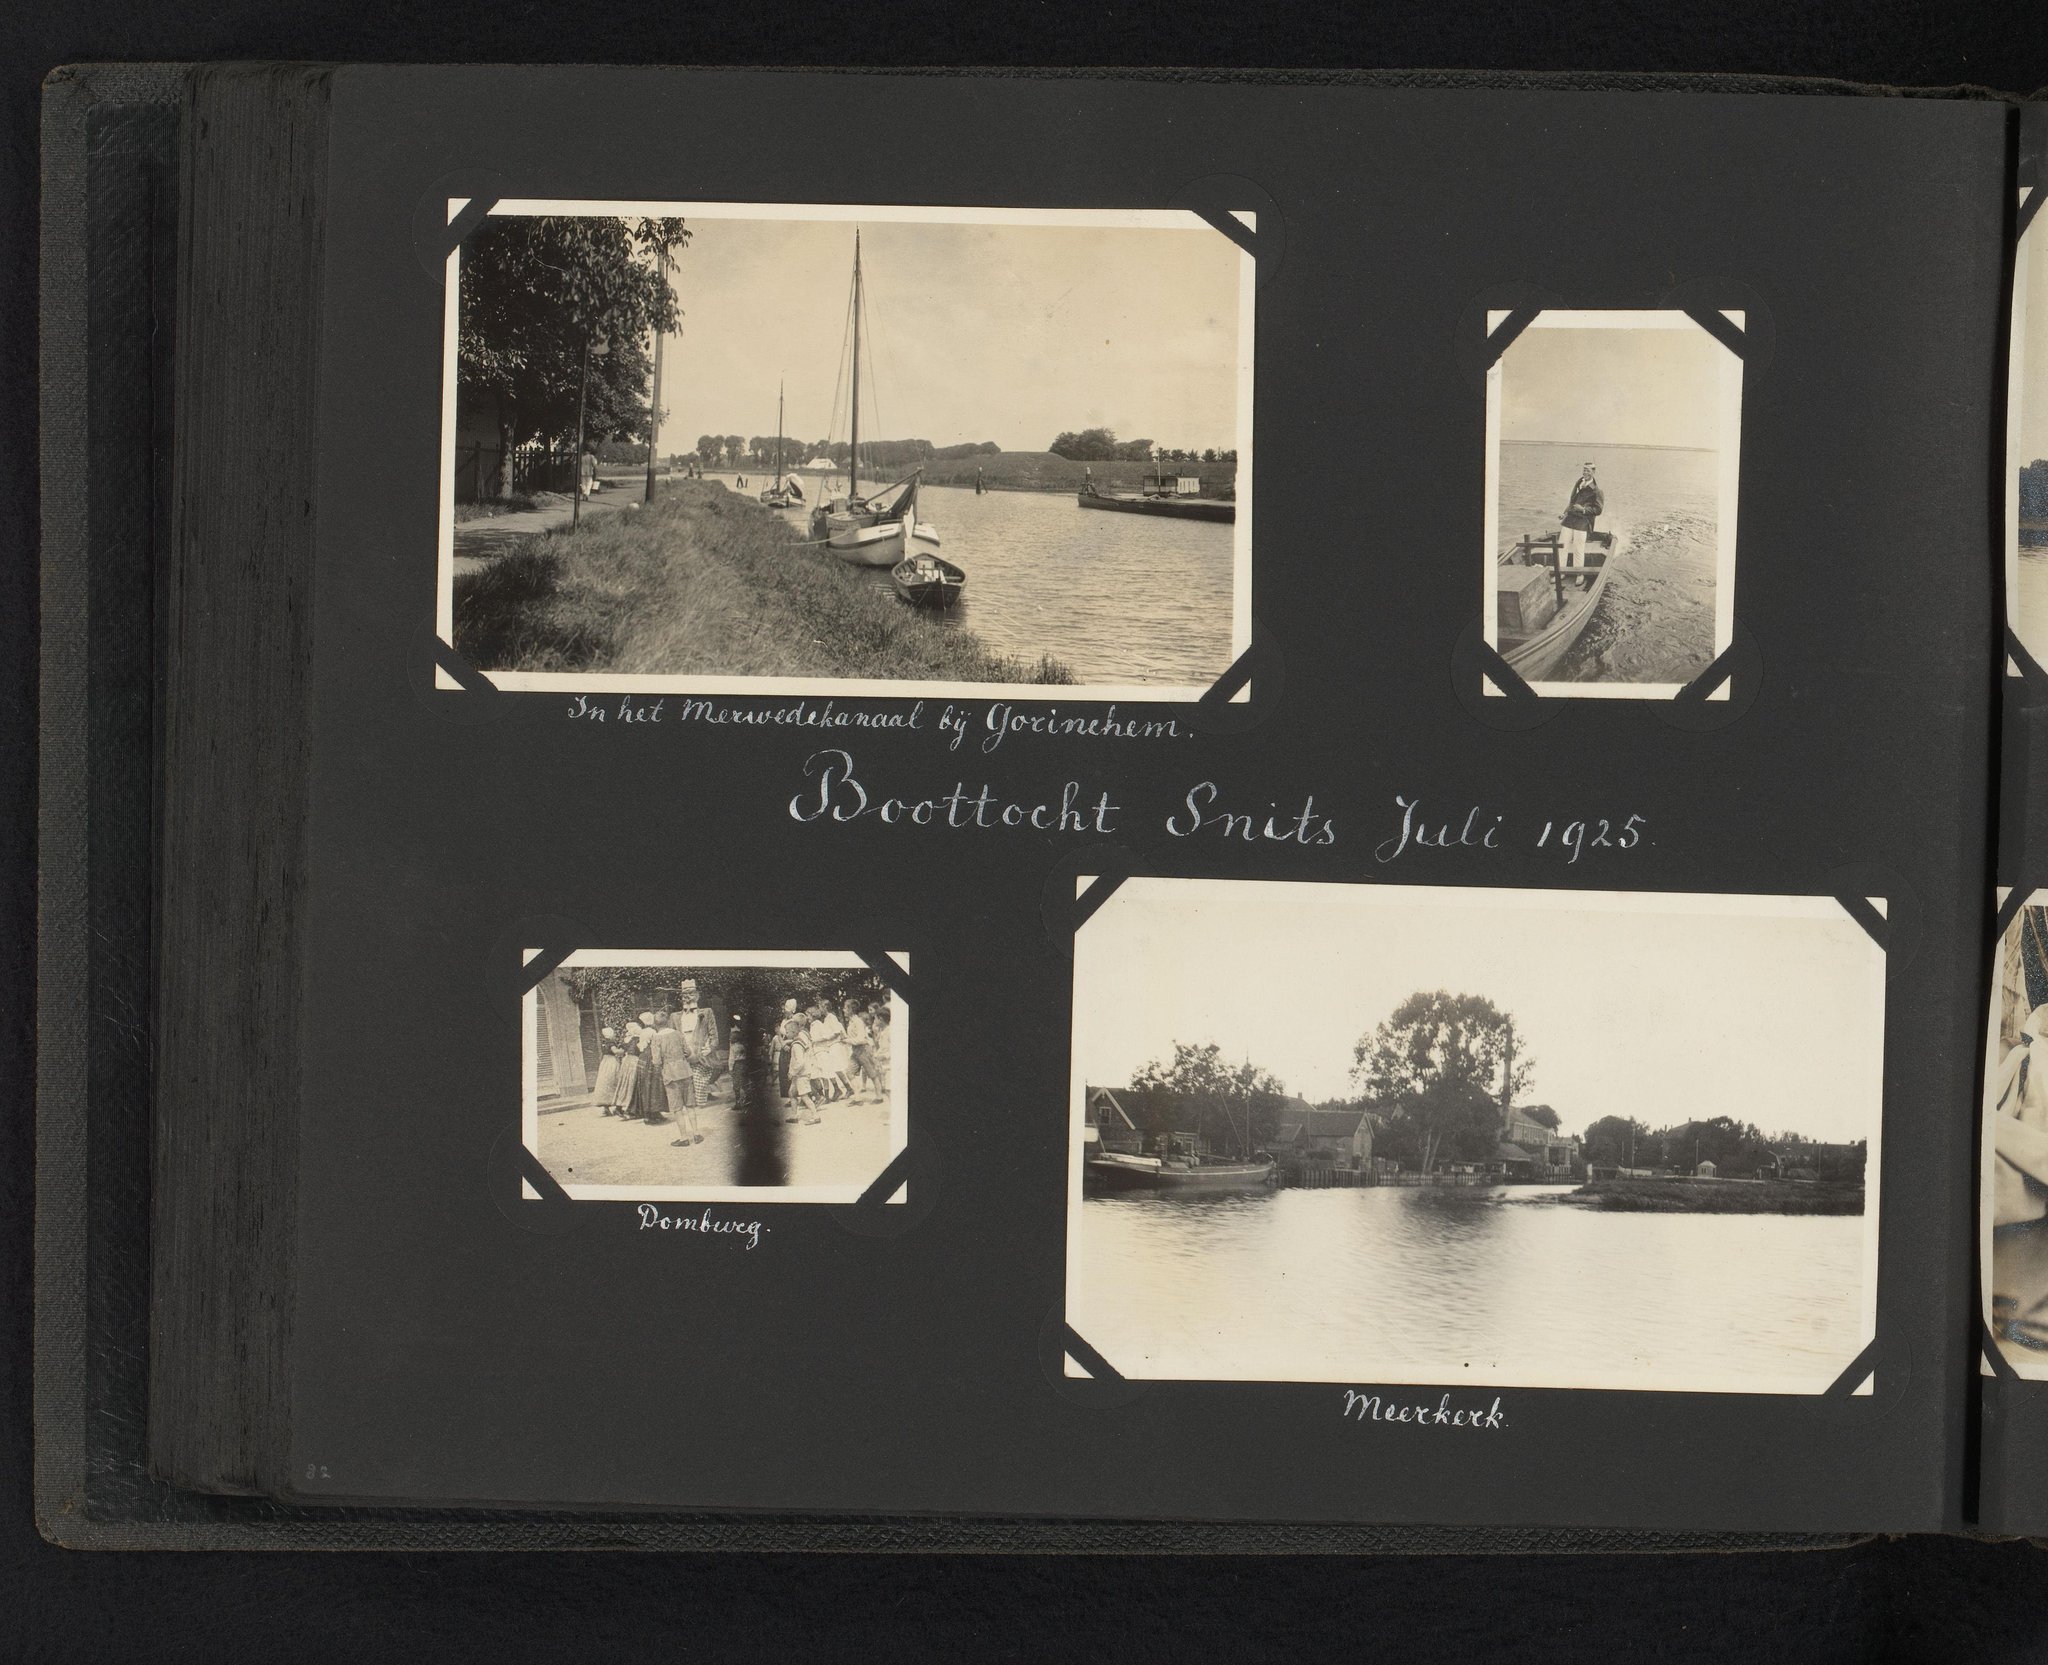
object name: photograph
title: Boottocht Snits Juli 1925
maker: hendrik herman van den berg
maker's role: amateurfotograaf, jurist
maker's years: 1875-1944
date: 1907-1925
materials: paper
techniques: gelatin silver print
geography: netherlands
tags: sailing-ship, sailing-boat, canal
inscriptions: inscription: ‘Domburg’, inscription: ‘In het Merwedekanaal bij Gorinchem’, inscription: ‘Meerkerk’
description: Deze foto's maken deel uit van een album.